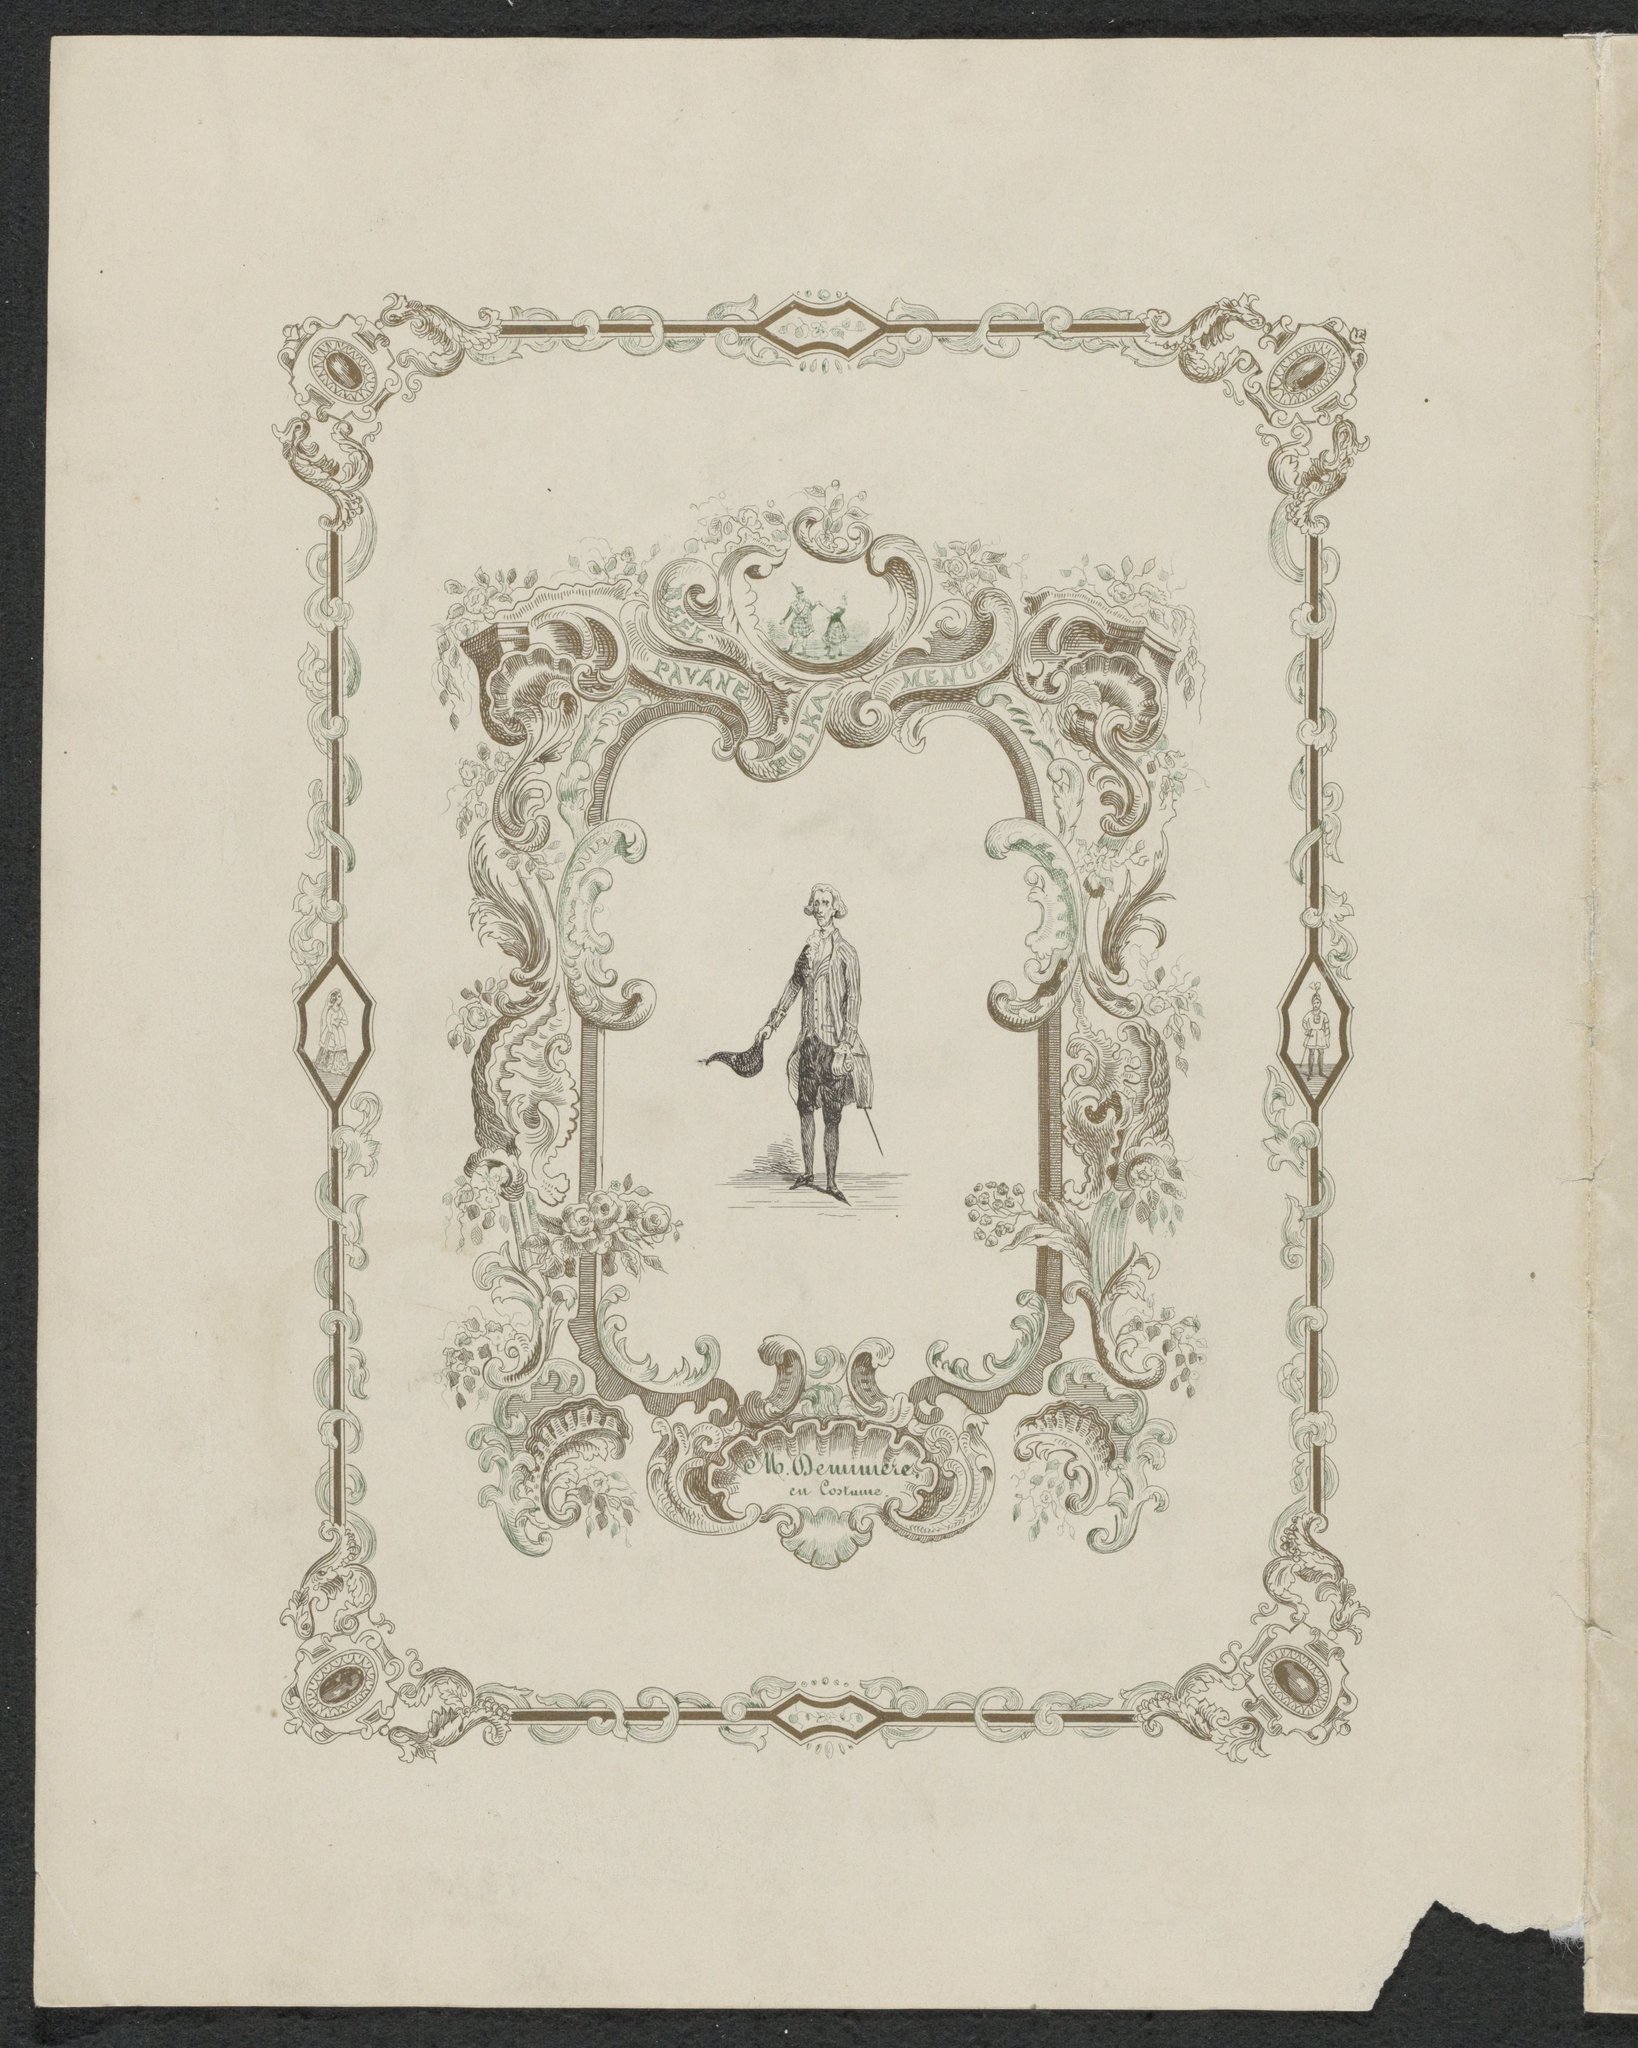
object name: print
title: Le Bal Costumé donné au Palais de S.A.R. Monseigneur le Prince d'Orange au 26 Fevrier 1845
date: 1845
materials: paper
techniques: lithograph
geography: the hague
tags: brussels, willem iii (koning der nederlanden), the hague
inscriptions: collector's mark: Lugt 2228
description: Achterzijde van een versierde papieren omslag gedrukt in goud en groen. Staande figuur van mr. Deminière, de Franse balletmeester aan het koninklijke hof, in kostuum, binnen ornamentele lijsten. Omslag om de gedrukte beschrijving door le Comte de Guldenlew van een gekostumeerd bal gehouden op het paleis van de prins van Oranje (de latere koning Willem III) in Den Haag op 26 februari 1845.